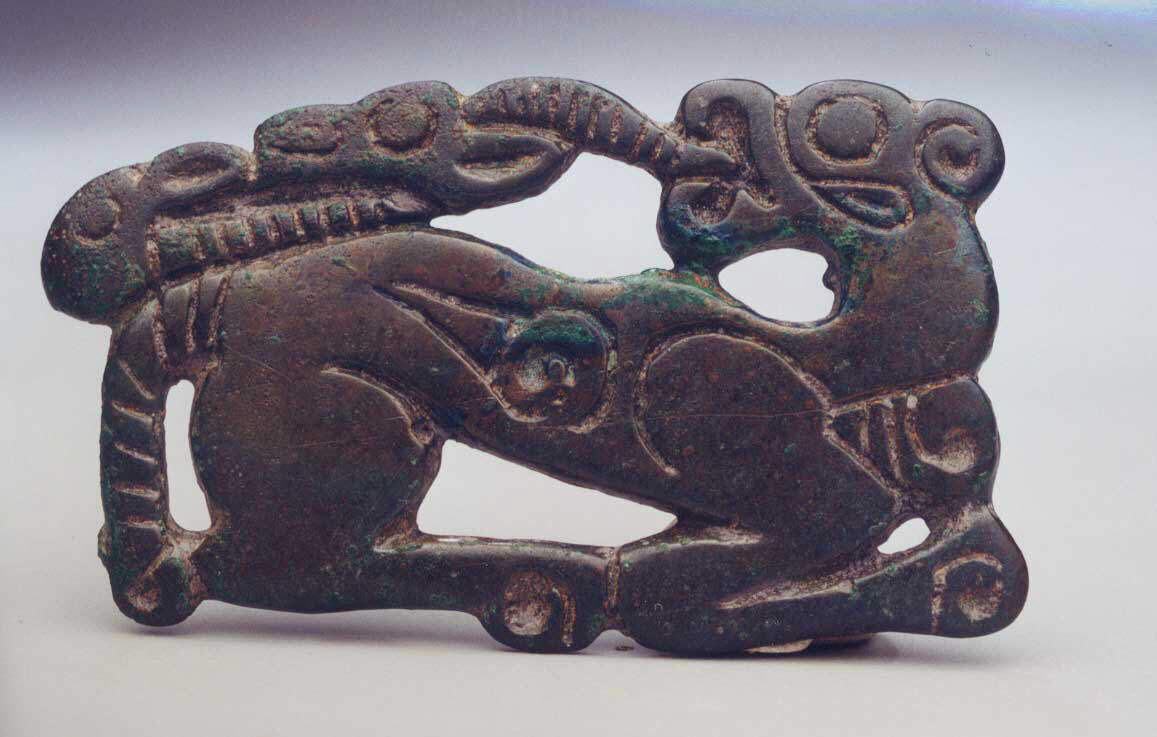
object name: belt plaque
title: Belt Plaque in the Shape of a Recumbent Tiger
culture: chinese or mongolian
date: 500-401 BCE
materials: bronze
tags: tigers